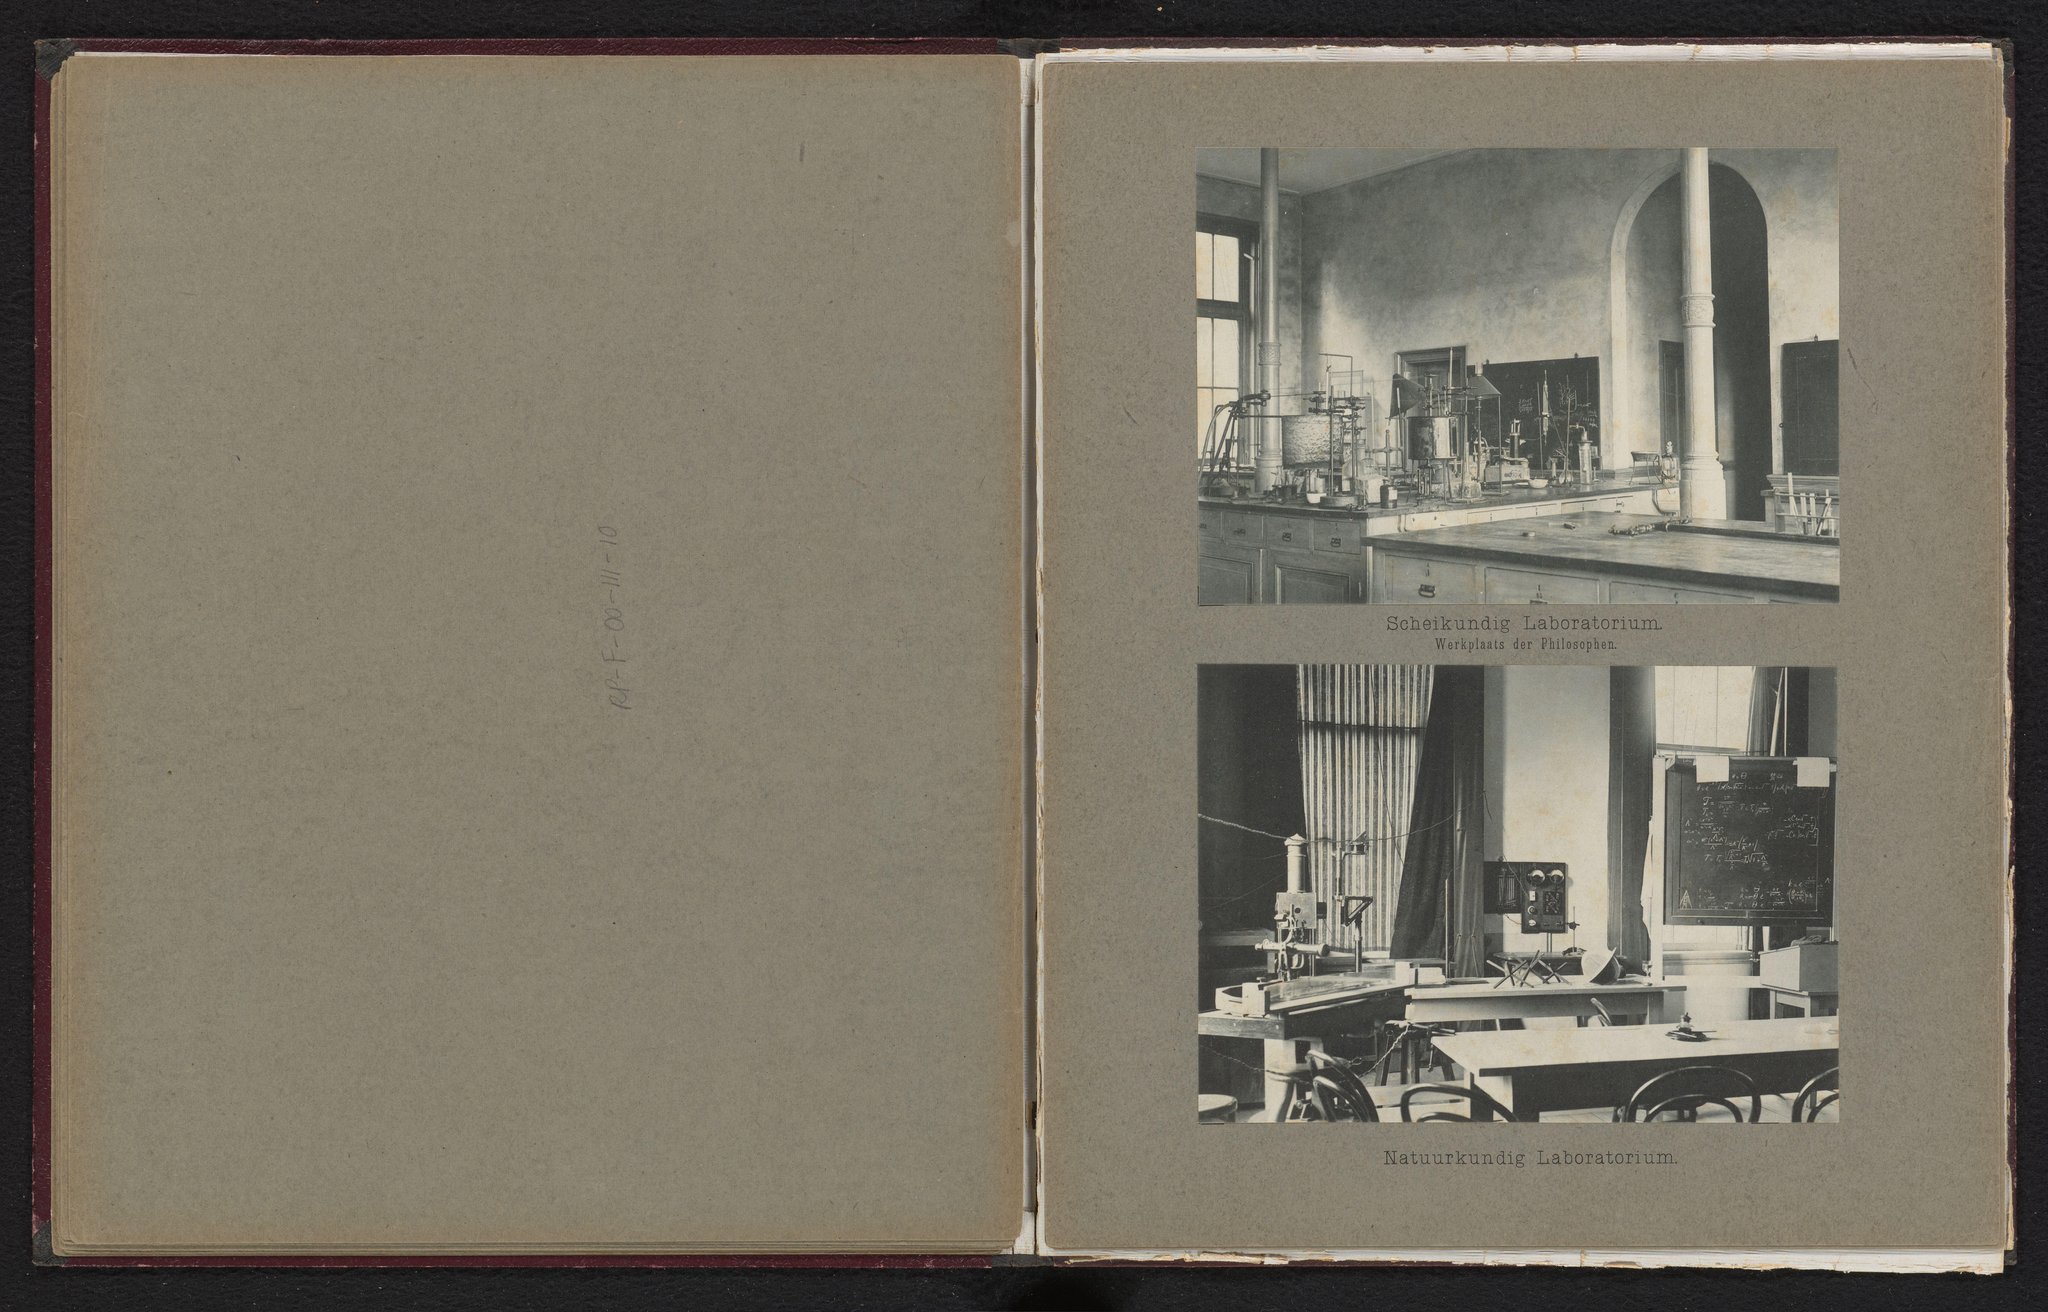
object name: photomechanical print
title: Scheikundig laboratorium van de Universiteit van Amsterdam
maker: Anonymous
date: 1902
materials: cardboard, paper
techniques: photograph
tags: university building, college, laboratory, research room, laboratory apparatus and equipment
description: Deze prent maakt deel uit van een omslag met vijftien lichtdrukken op twaalf kartonnen bladen.